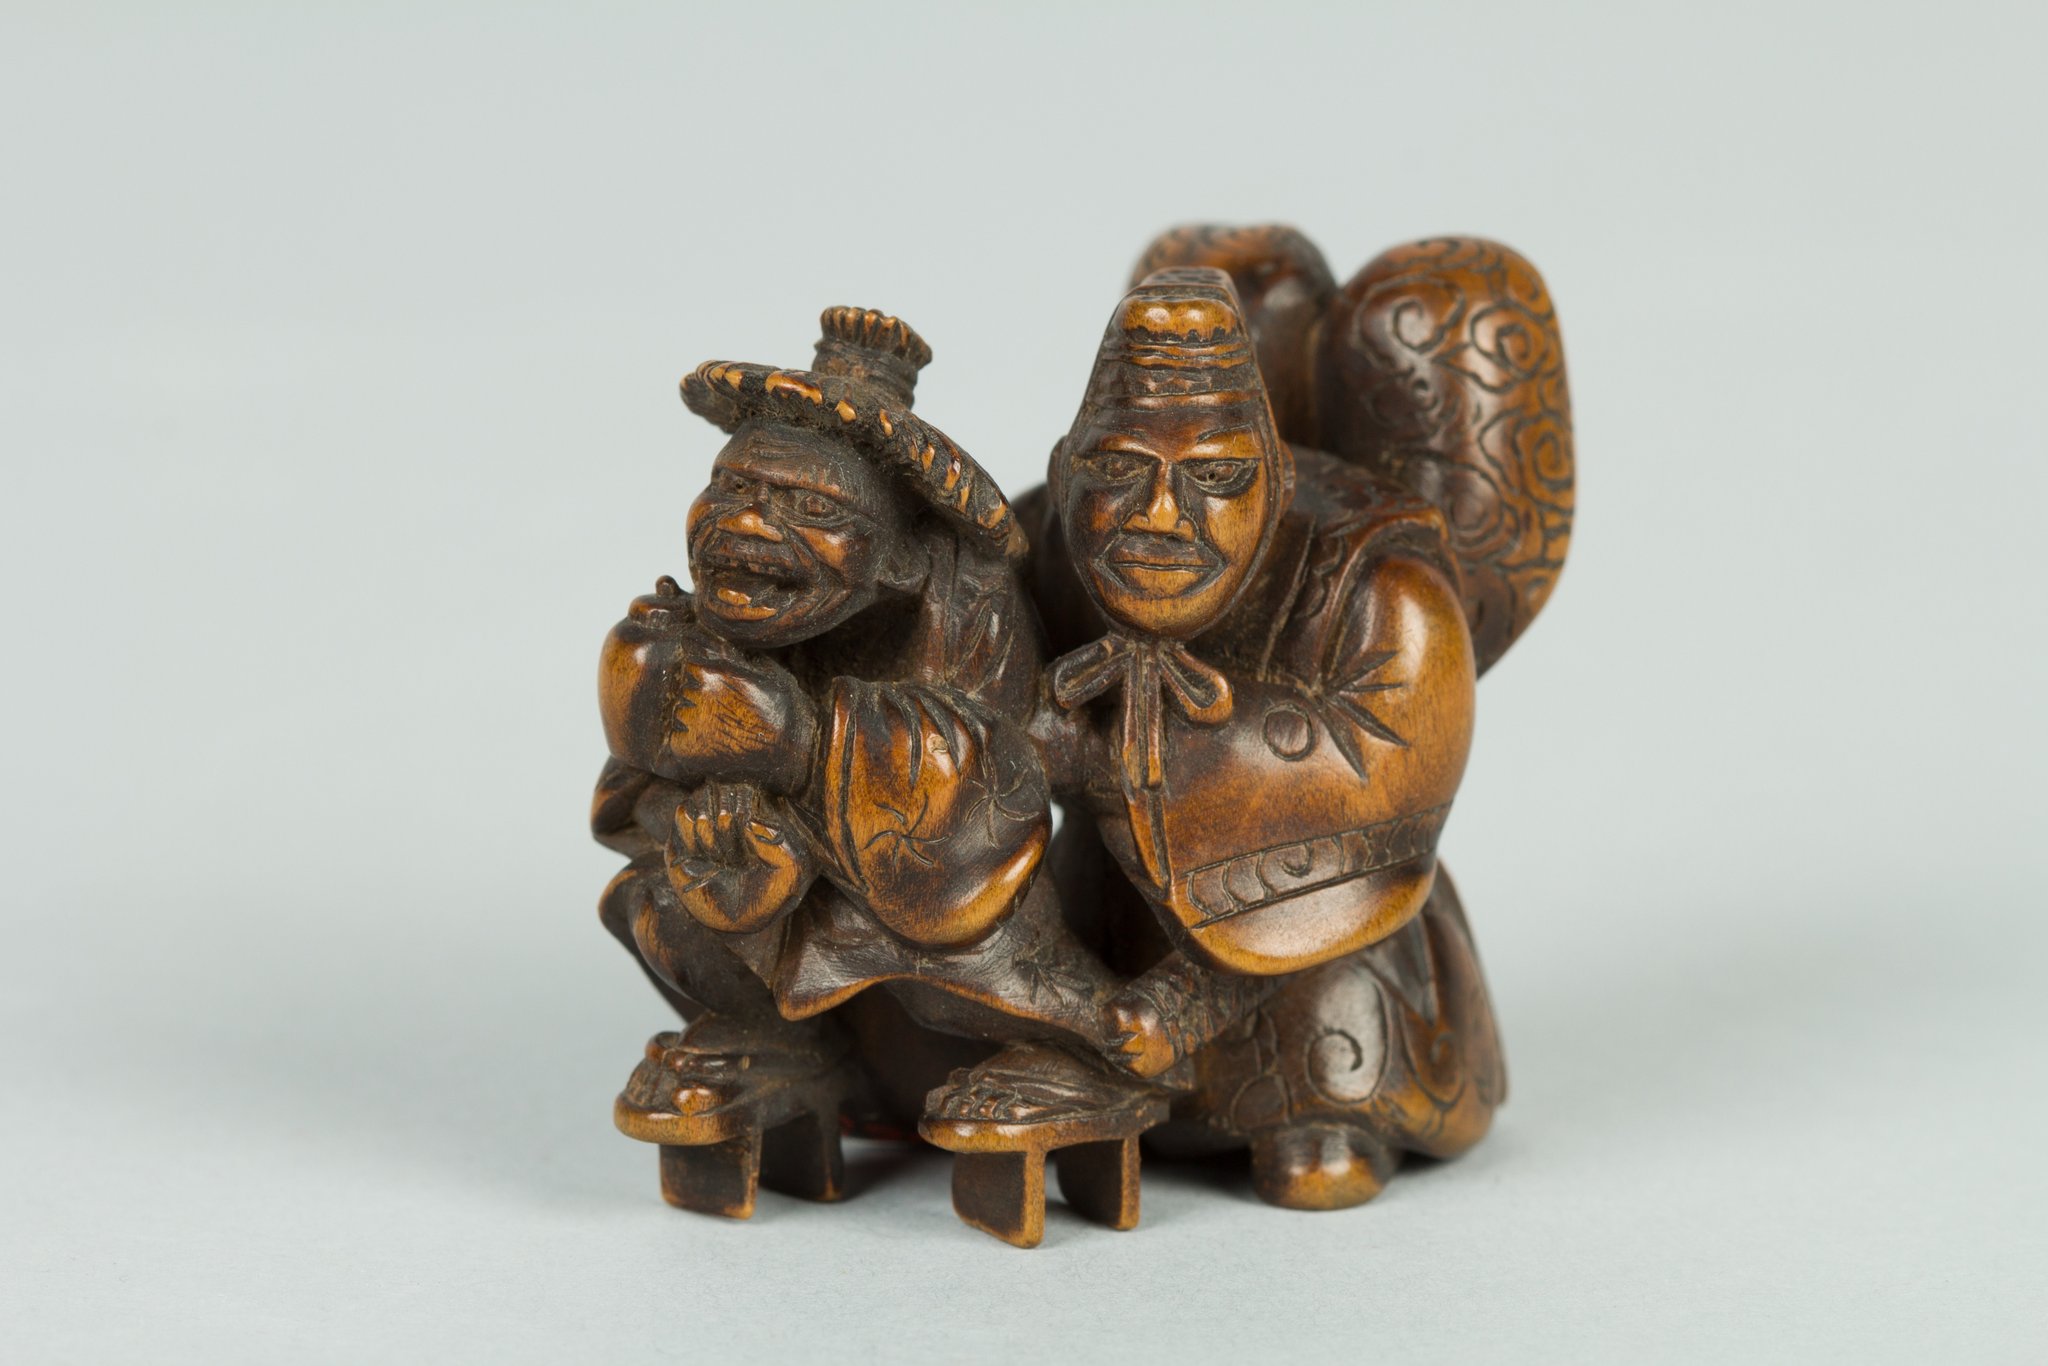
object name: netsuke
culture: japanese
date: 1801-1900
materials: wood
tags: men